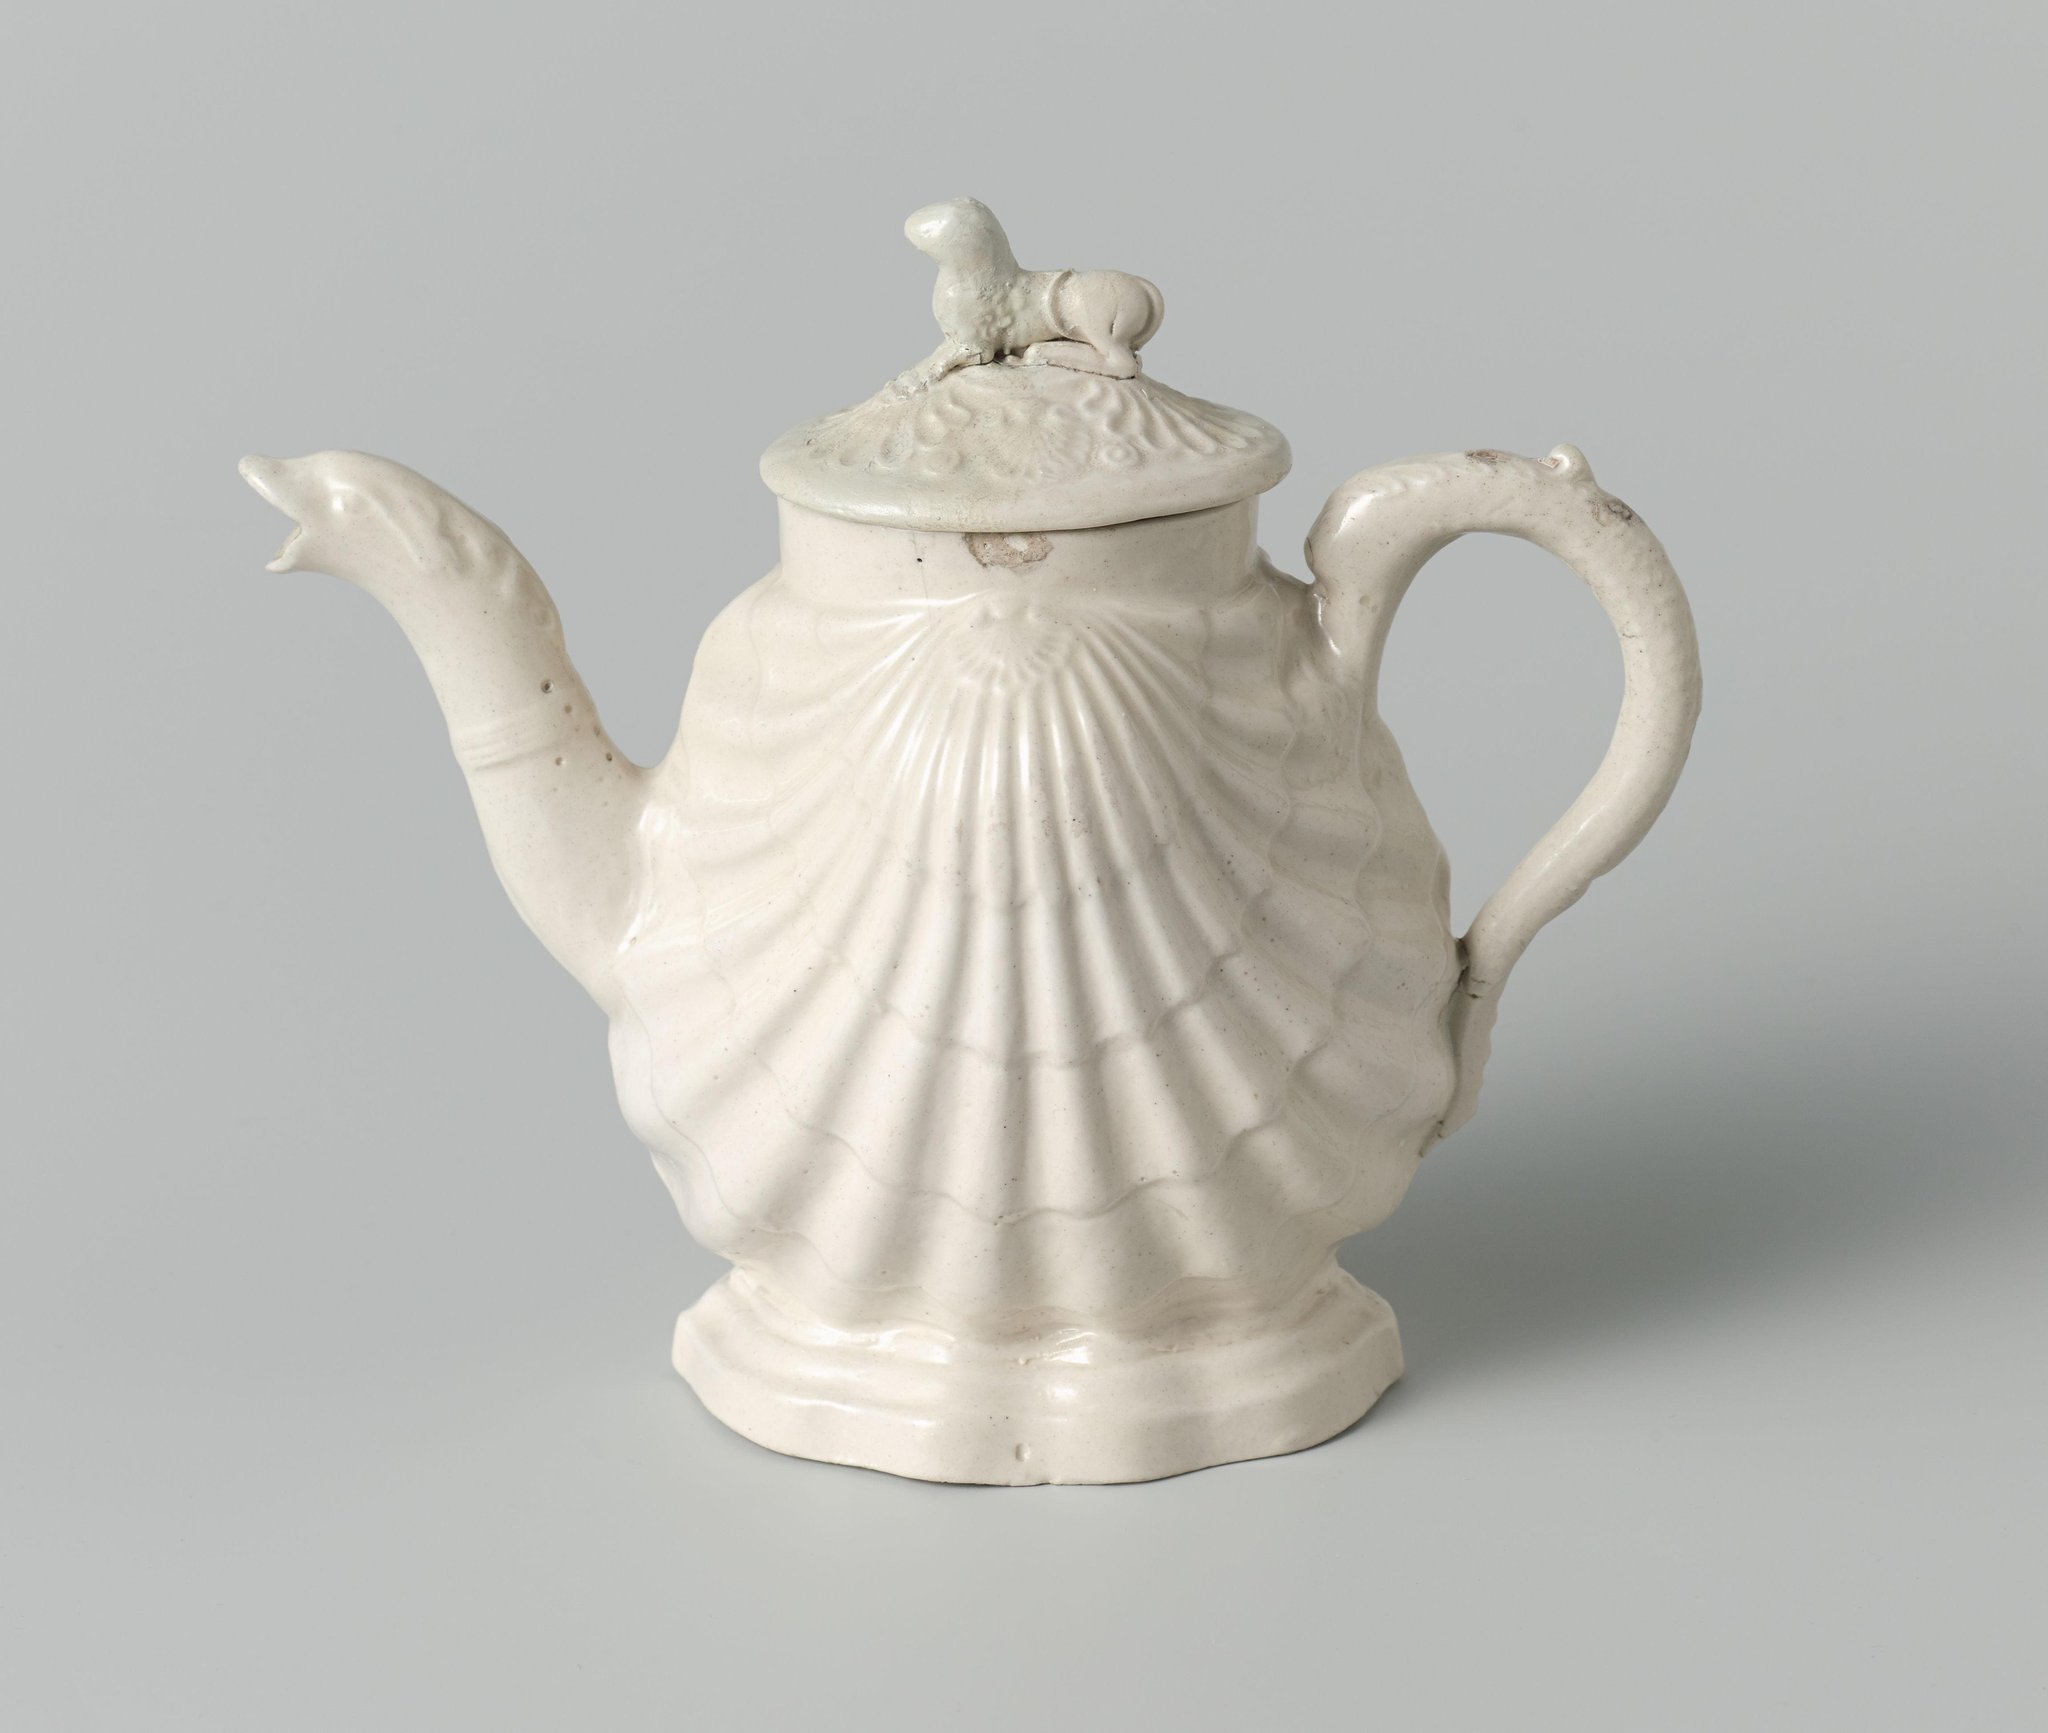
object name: lid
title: Deksel van wit steengoed met zoutglazuur; Whieldon ware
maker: Anonymous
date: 1750-1760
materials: stoneware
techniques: salt glaze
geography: england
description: Het deksel heeft een liggende hond of leeuw als knop.